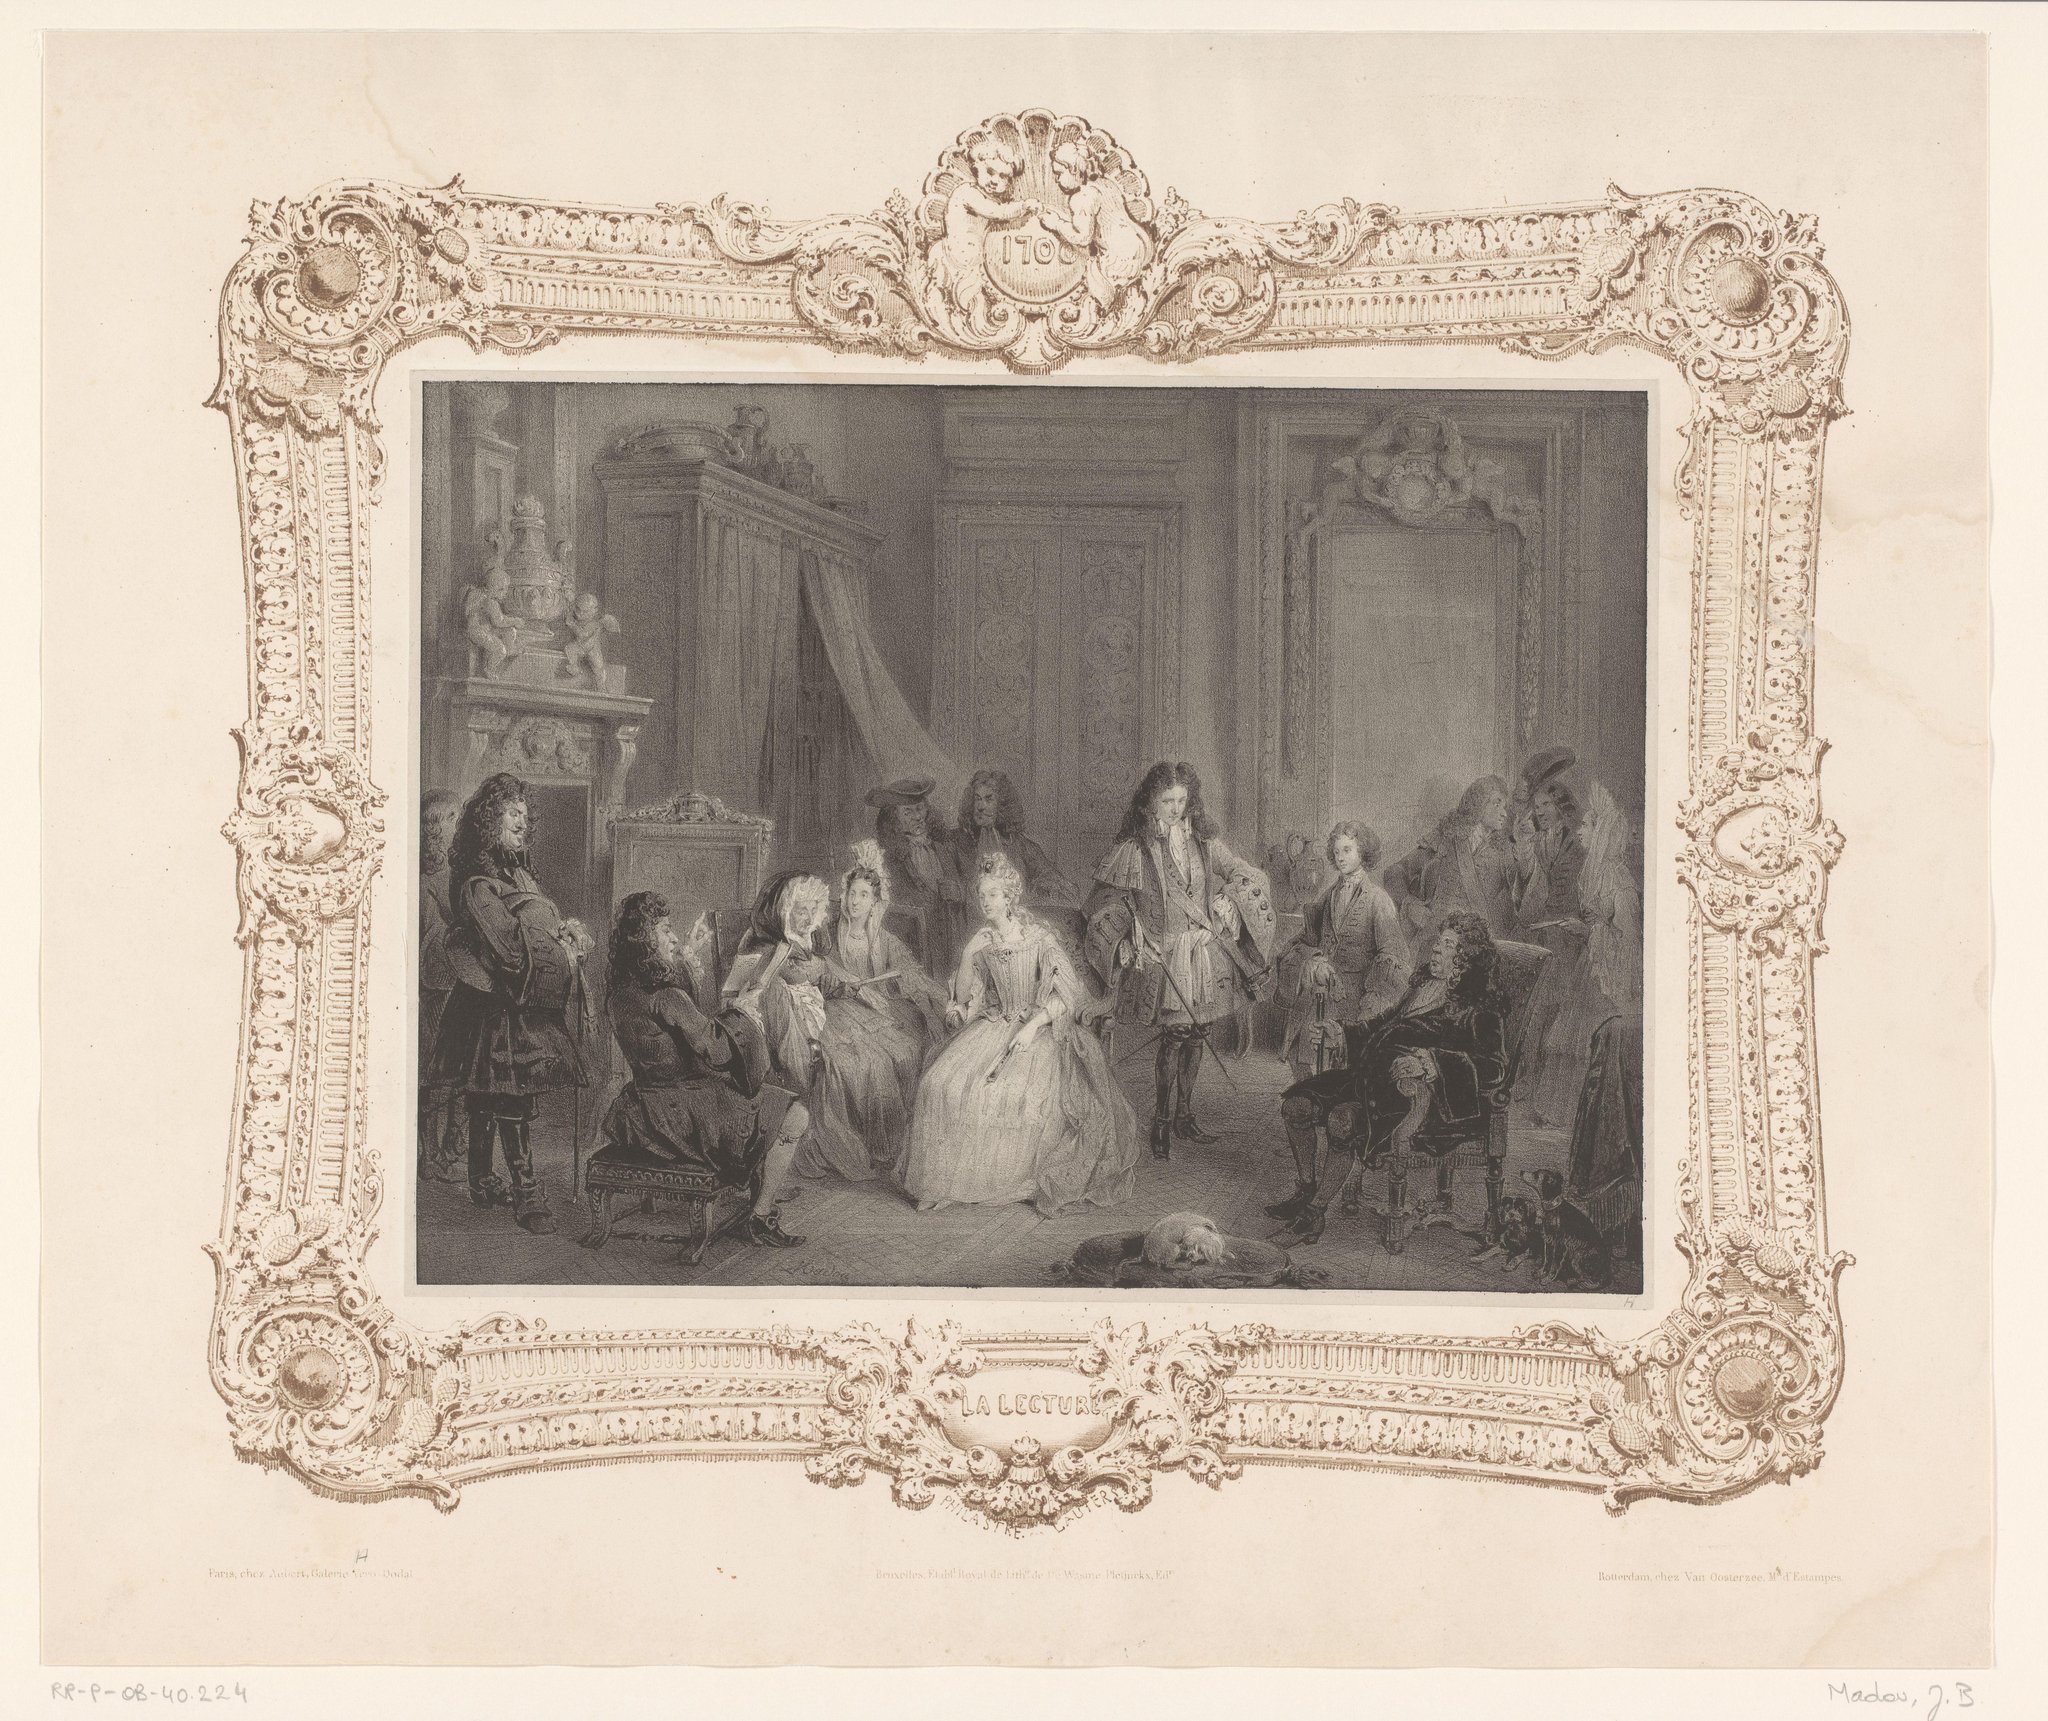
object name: print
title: La lecture 1700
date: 1835-1837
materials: paper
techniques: lithograph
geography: rotterdam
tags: story teller; listening to story teller, interior of the house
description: De voorstelling is vervaardigd door Madou, de omlijsting door Paulus Lauters en Philastre.